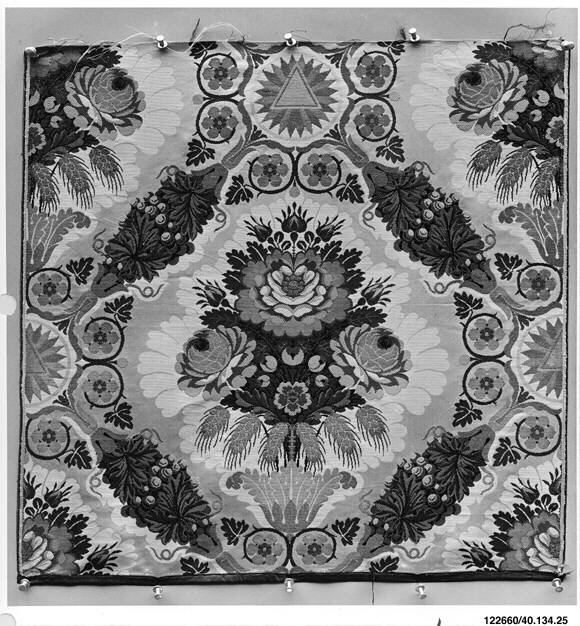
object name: piece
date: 1801-1833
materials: metal thread, silk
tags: flowers